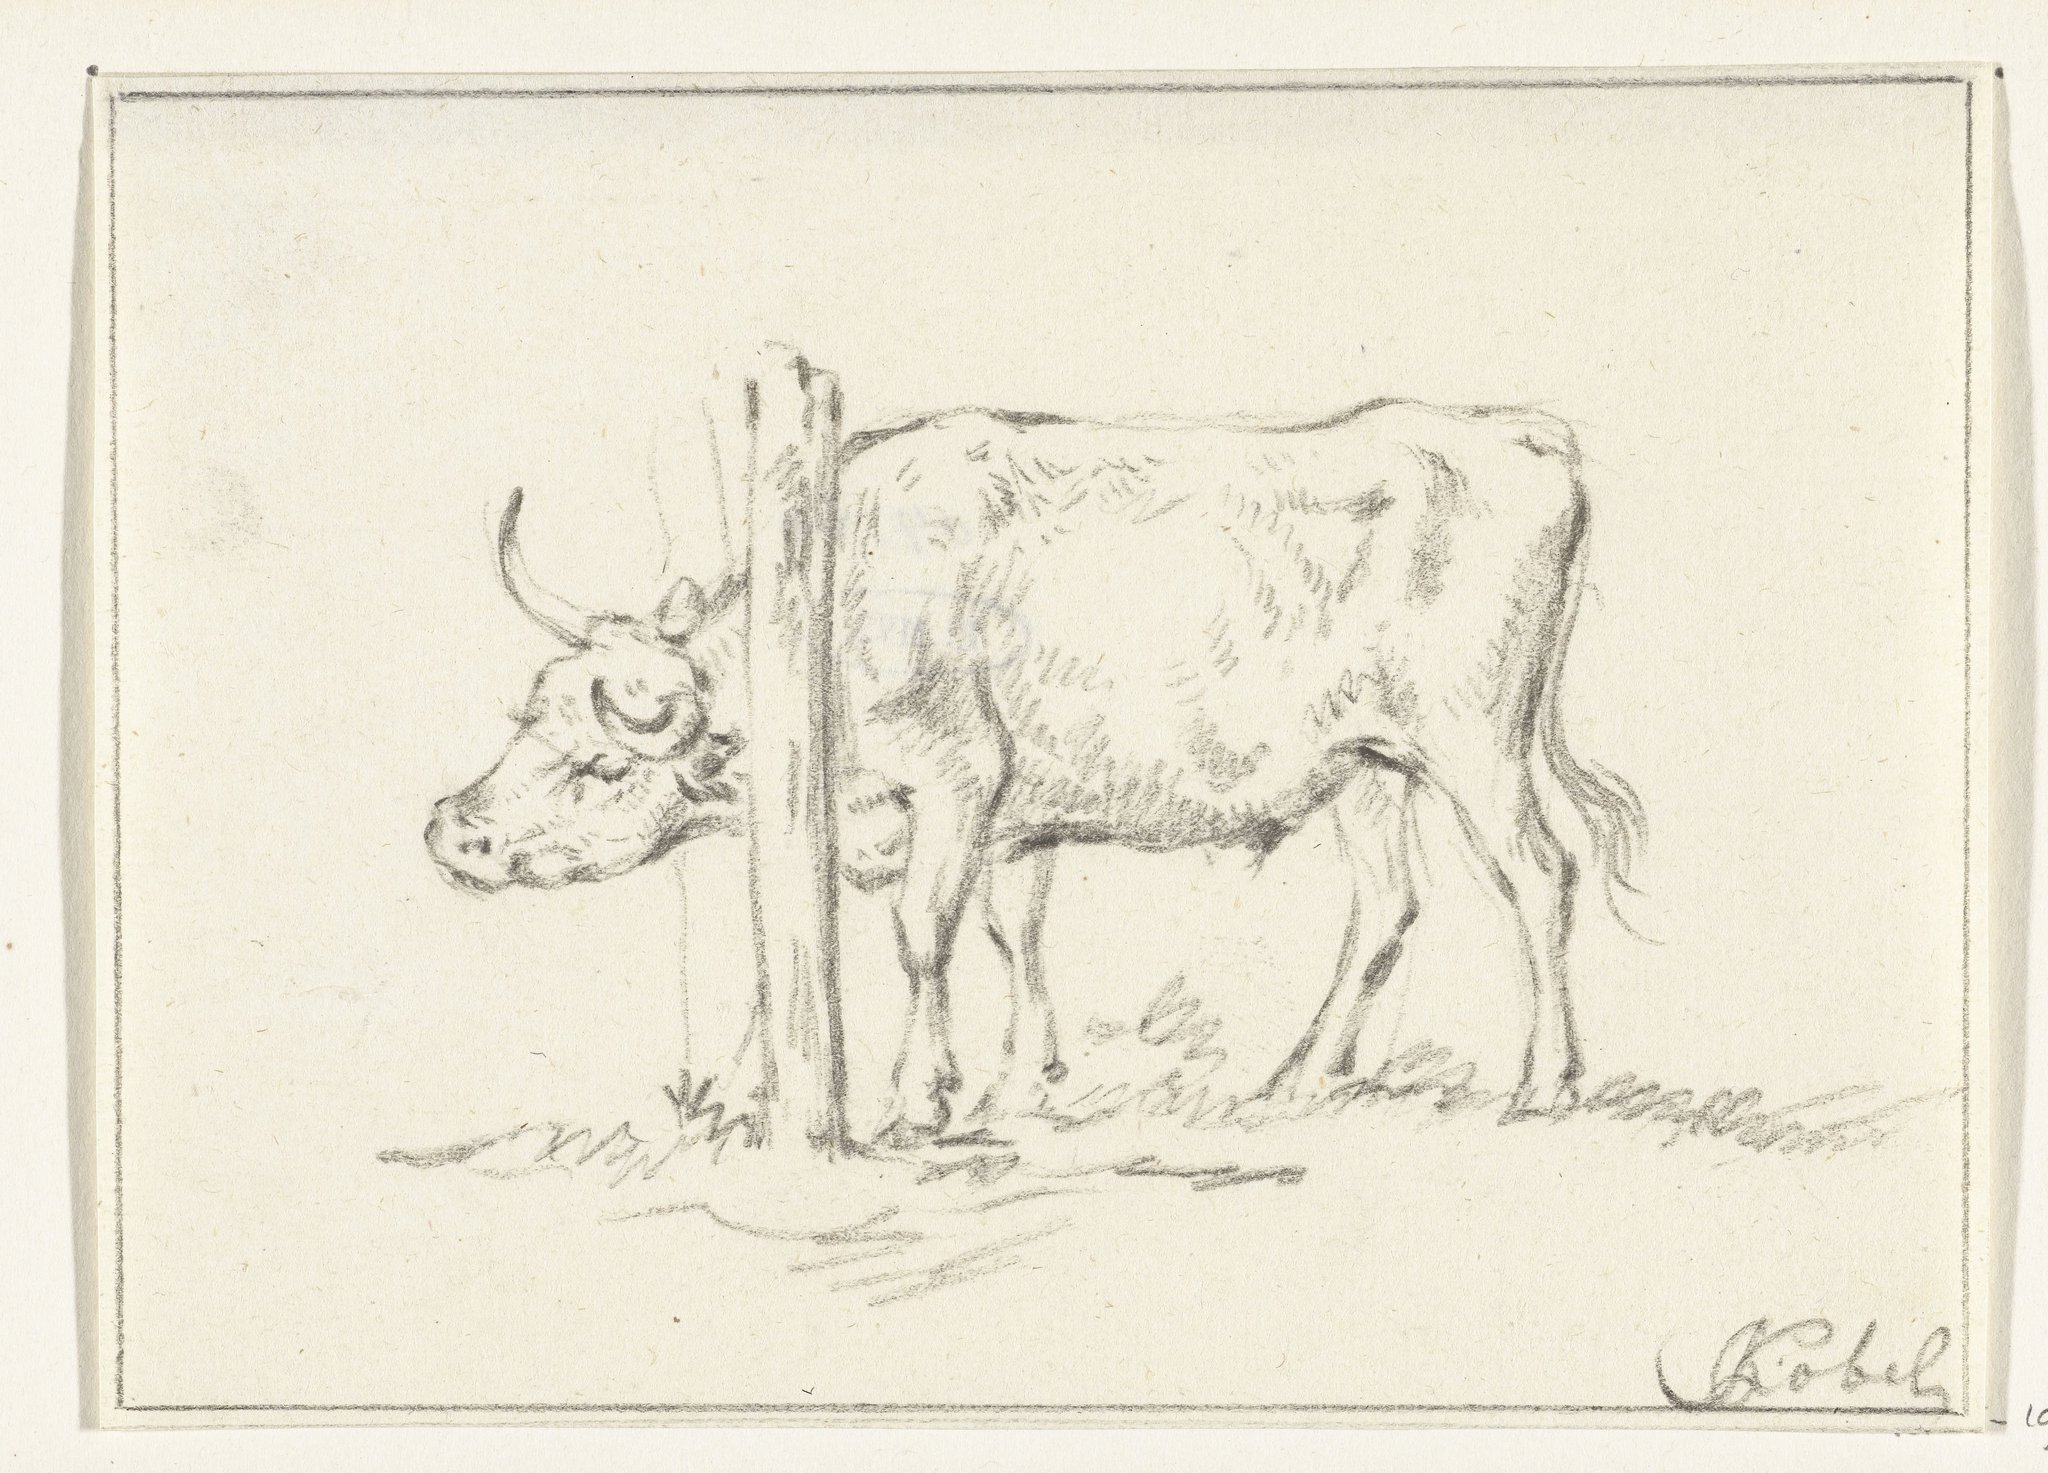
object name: drawing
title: Staande koe, met zijn kop tussen palen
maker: jean bernard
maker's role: draughtsman, print maker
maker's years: 1765-1833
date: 1775-1833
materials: chalk, paper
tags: cow